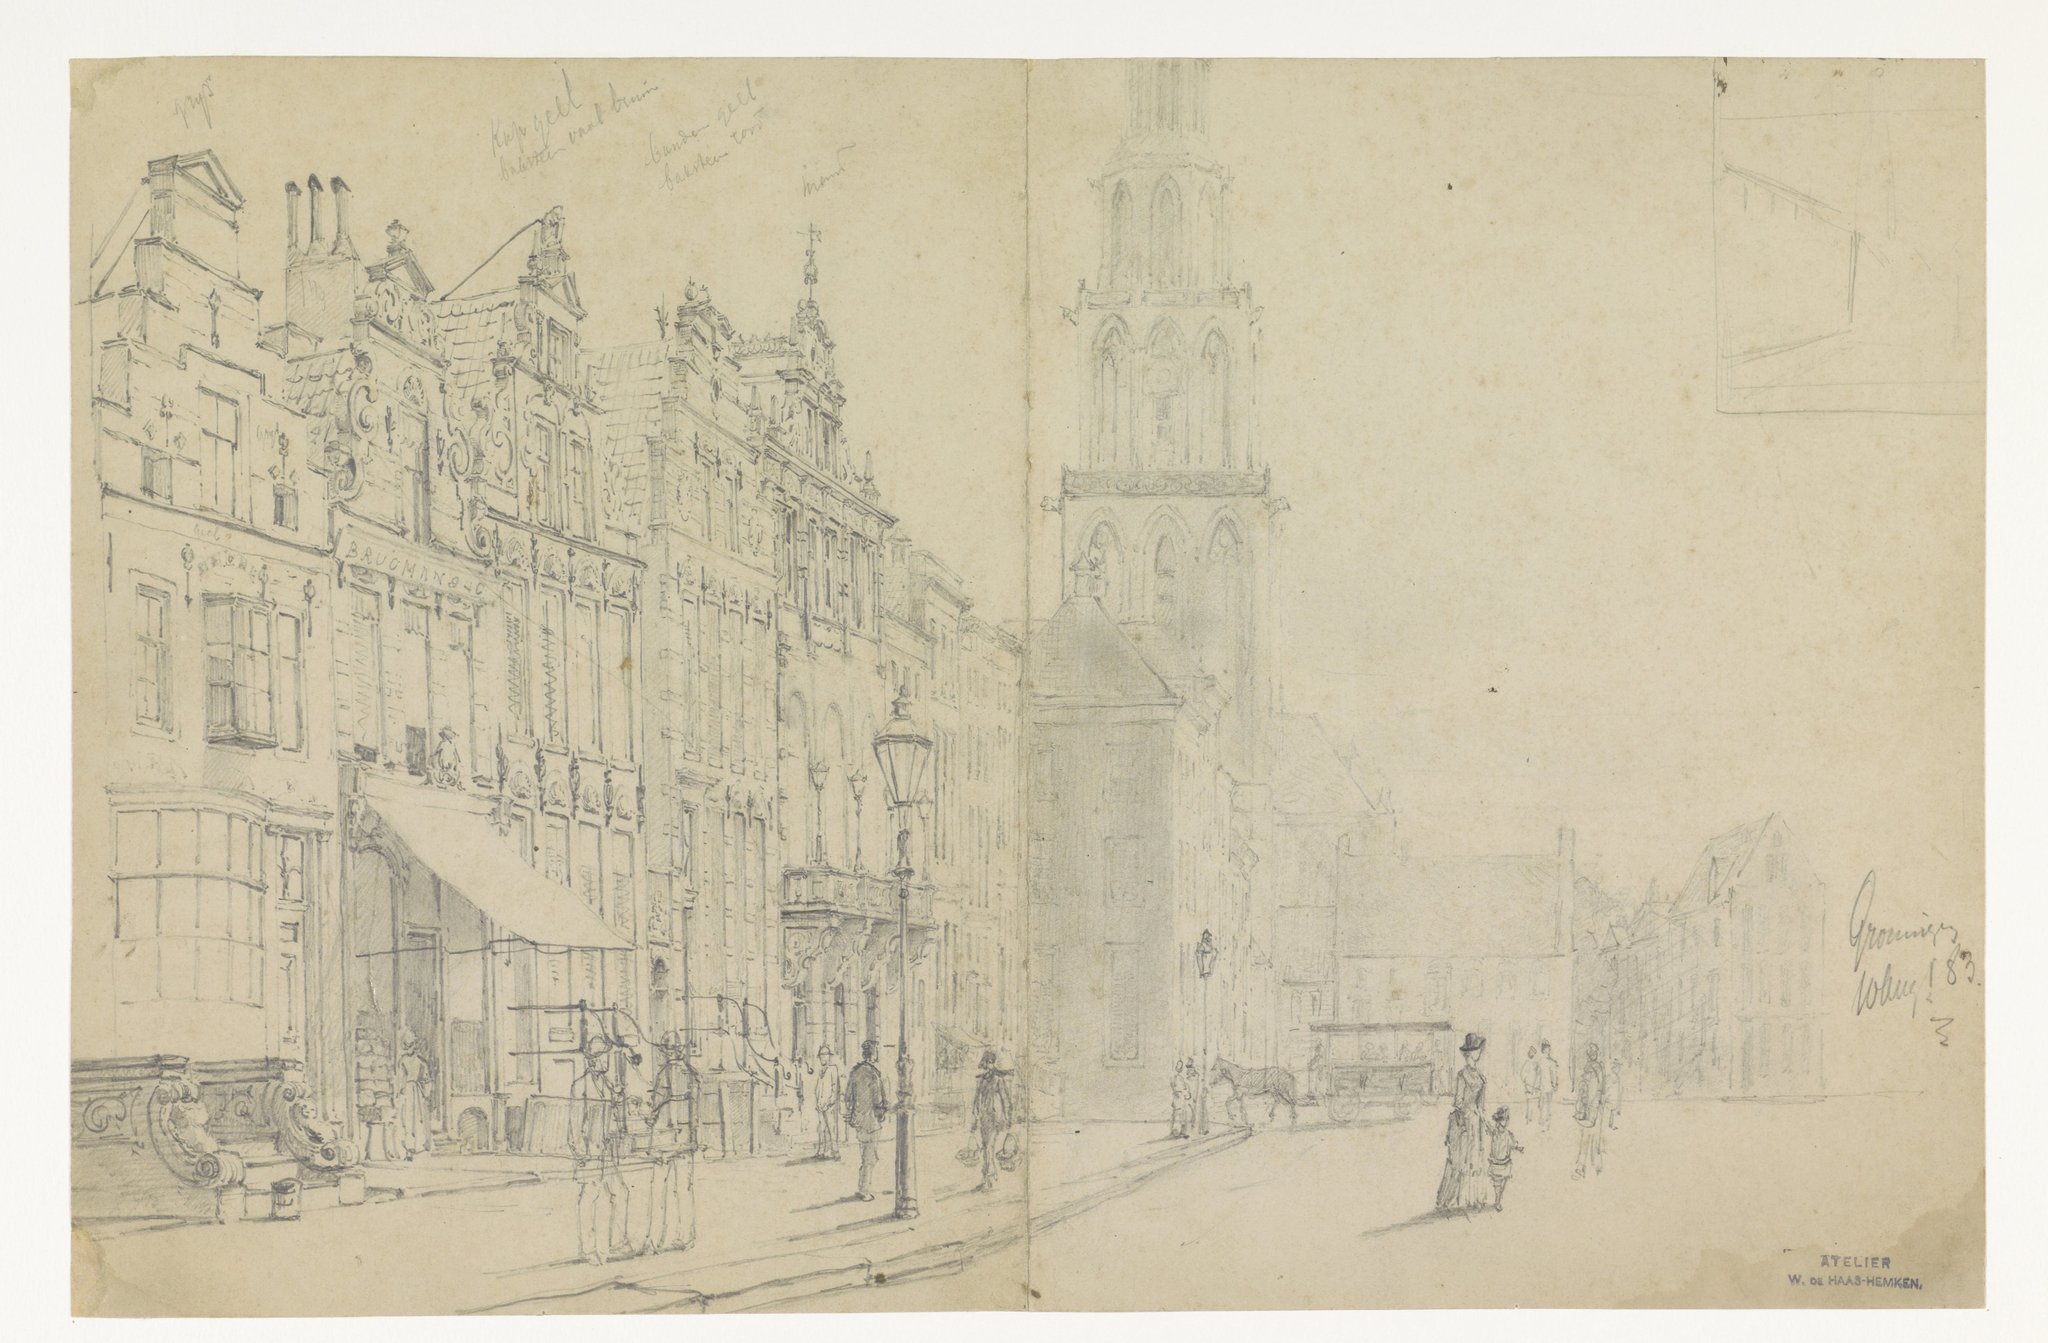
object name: drawing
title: Gezicht op de Grote Markt in Groningen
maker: willem de haas hemken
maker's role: draughtsman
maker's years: 1831-1911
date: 1883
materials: paper, pencil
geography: groningen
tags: grote markt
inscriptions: date: ‘10 Aug '83’, annotation: ‘Groningen’, workshop stamp